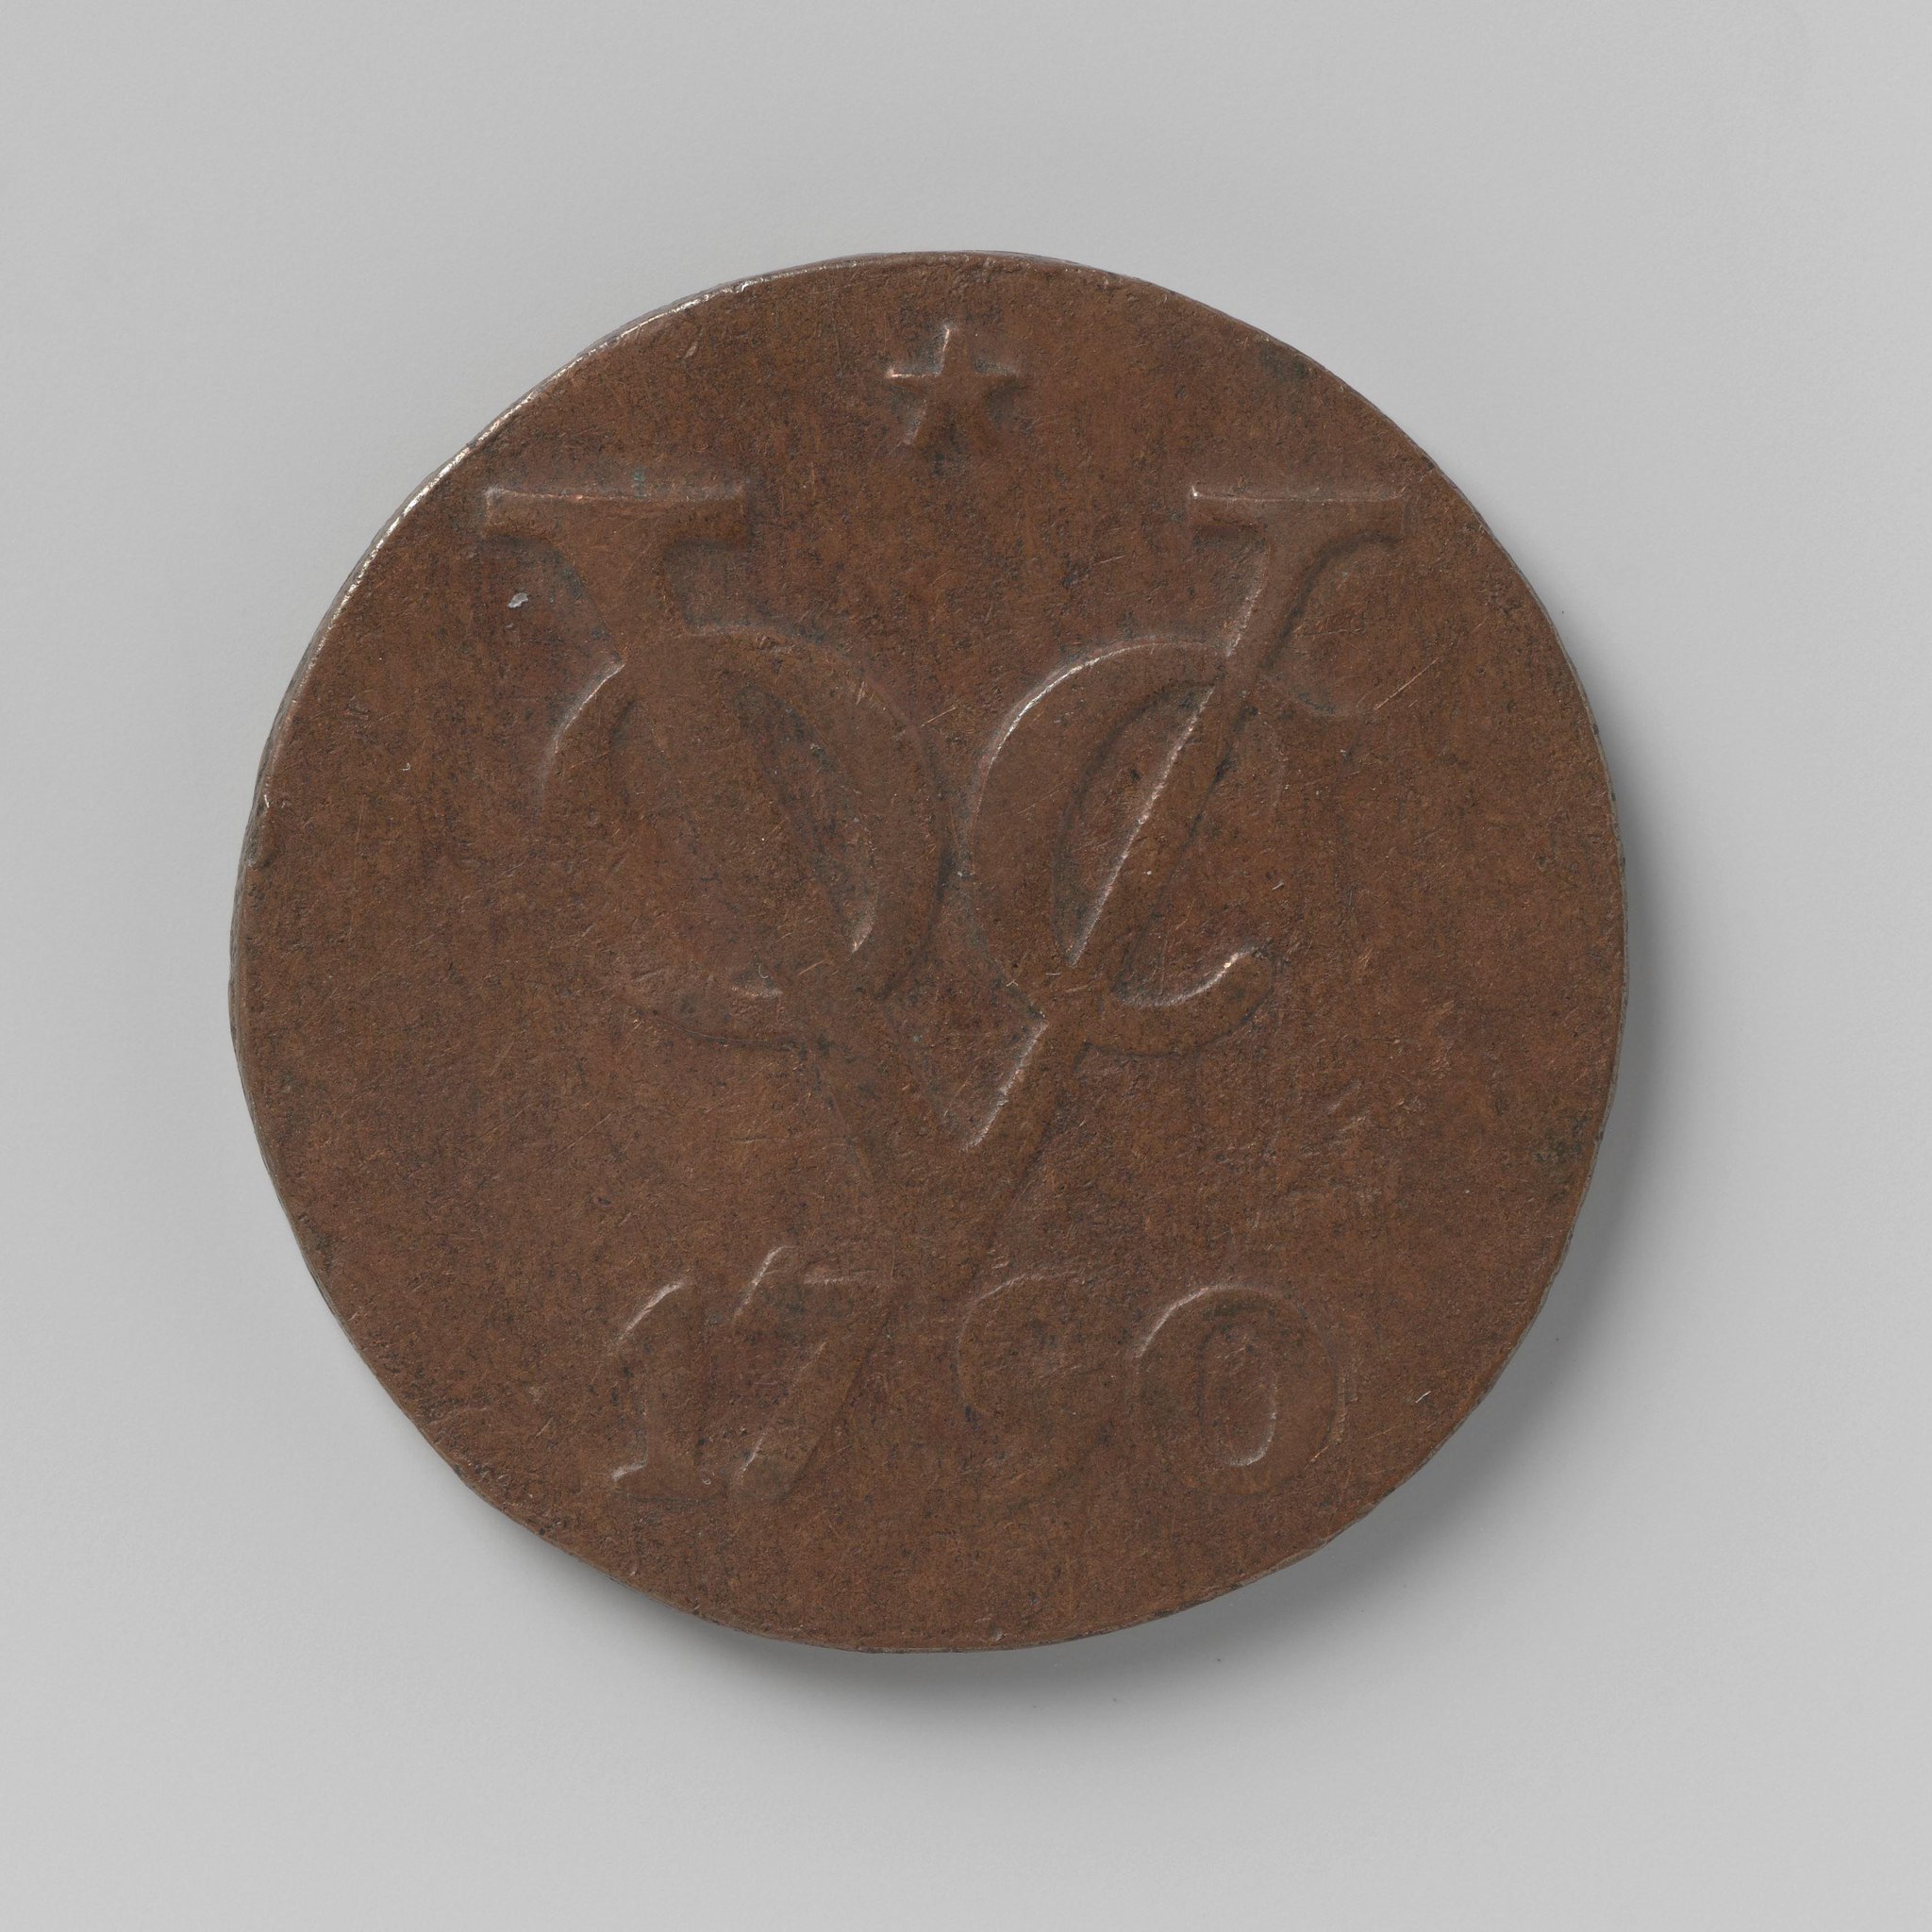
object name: coin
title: VOC, dubbele duit op naam van de stad Utrecht met jaartal1790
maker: william ii of the netherlands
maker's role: koning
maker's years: 1792-1849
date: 1840-1843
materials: copper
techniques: striking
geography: surabaya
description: Koperen munt. Voorzijde: op balk, waaronder guirlande, staand, door twee leeuwen gehouden gekroond wapenschild van de stad Utrecht. Keerzijde: monogram van de VOC, waarboven muntteken ster en waaronder fictief jaartal 1790. Gladde rand.